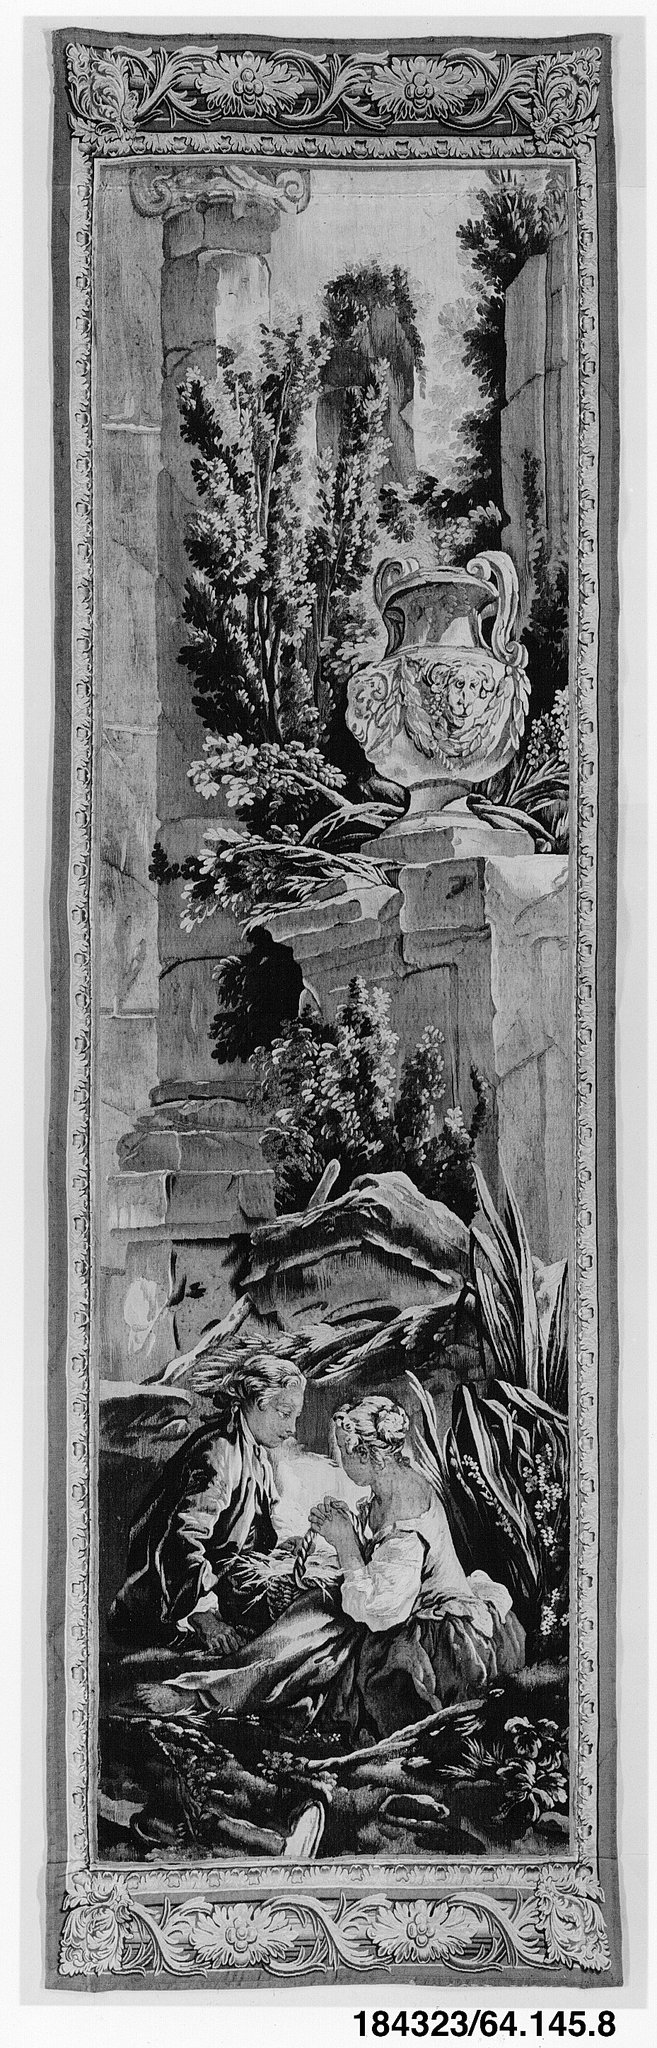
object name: tapestry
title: The Egg Seller from a set of the Italian Village Scenes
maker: françois boucher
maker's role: artist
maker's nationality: french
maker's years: 1703-1770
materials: silk, wool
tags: men,women,eggs